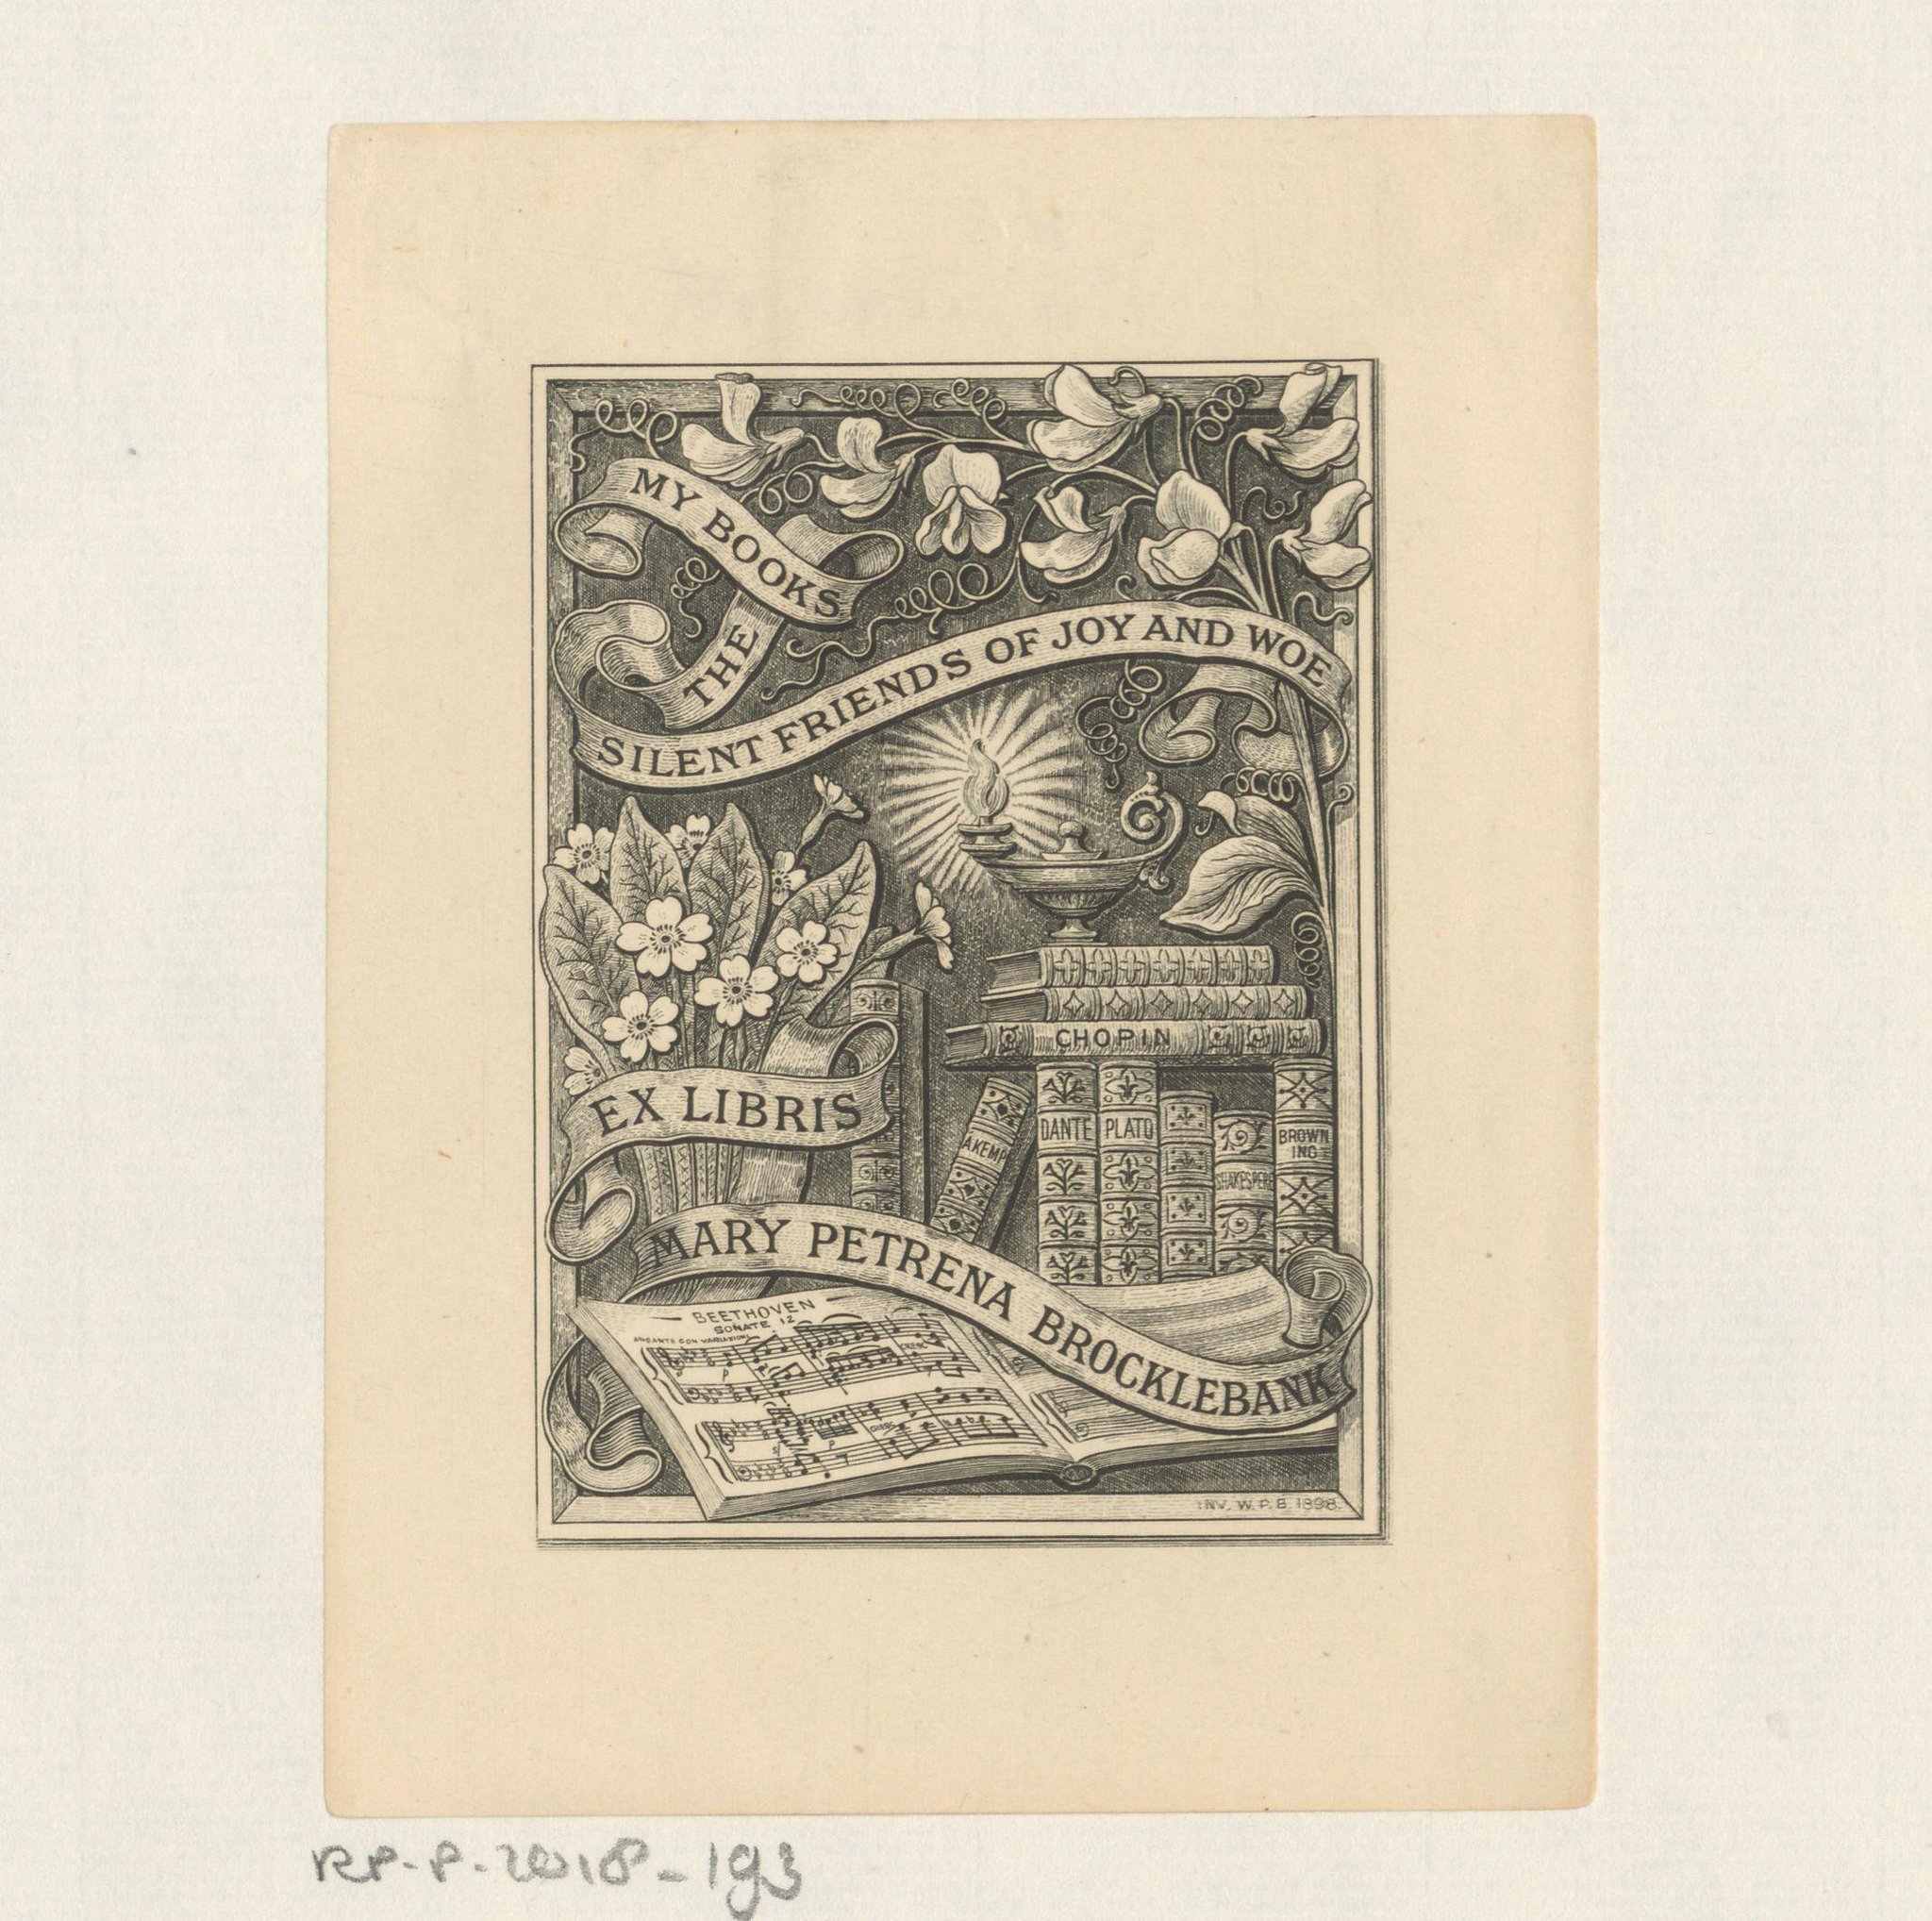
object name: bookplate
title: My books the silent friends of joy and woe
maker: william phillips barrett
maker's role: print maker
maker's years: 1861-1938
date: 1898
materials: paper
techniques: engraving, etching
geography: england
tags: flowers: forget-me-not, book, oil-lamp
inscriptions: date